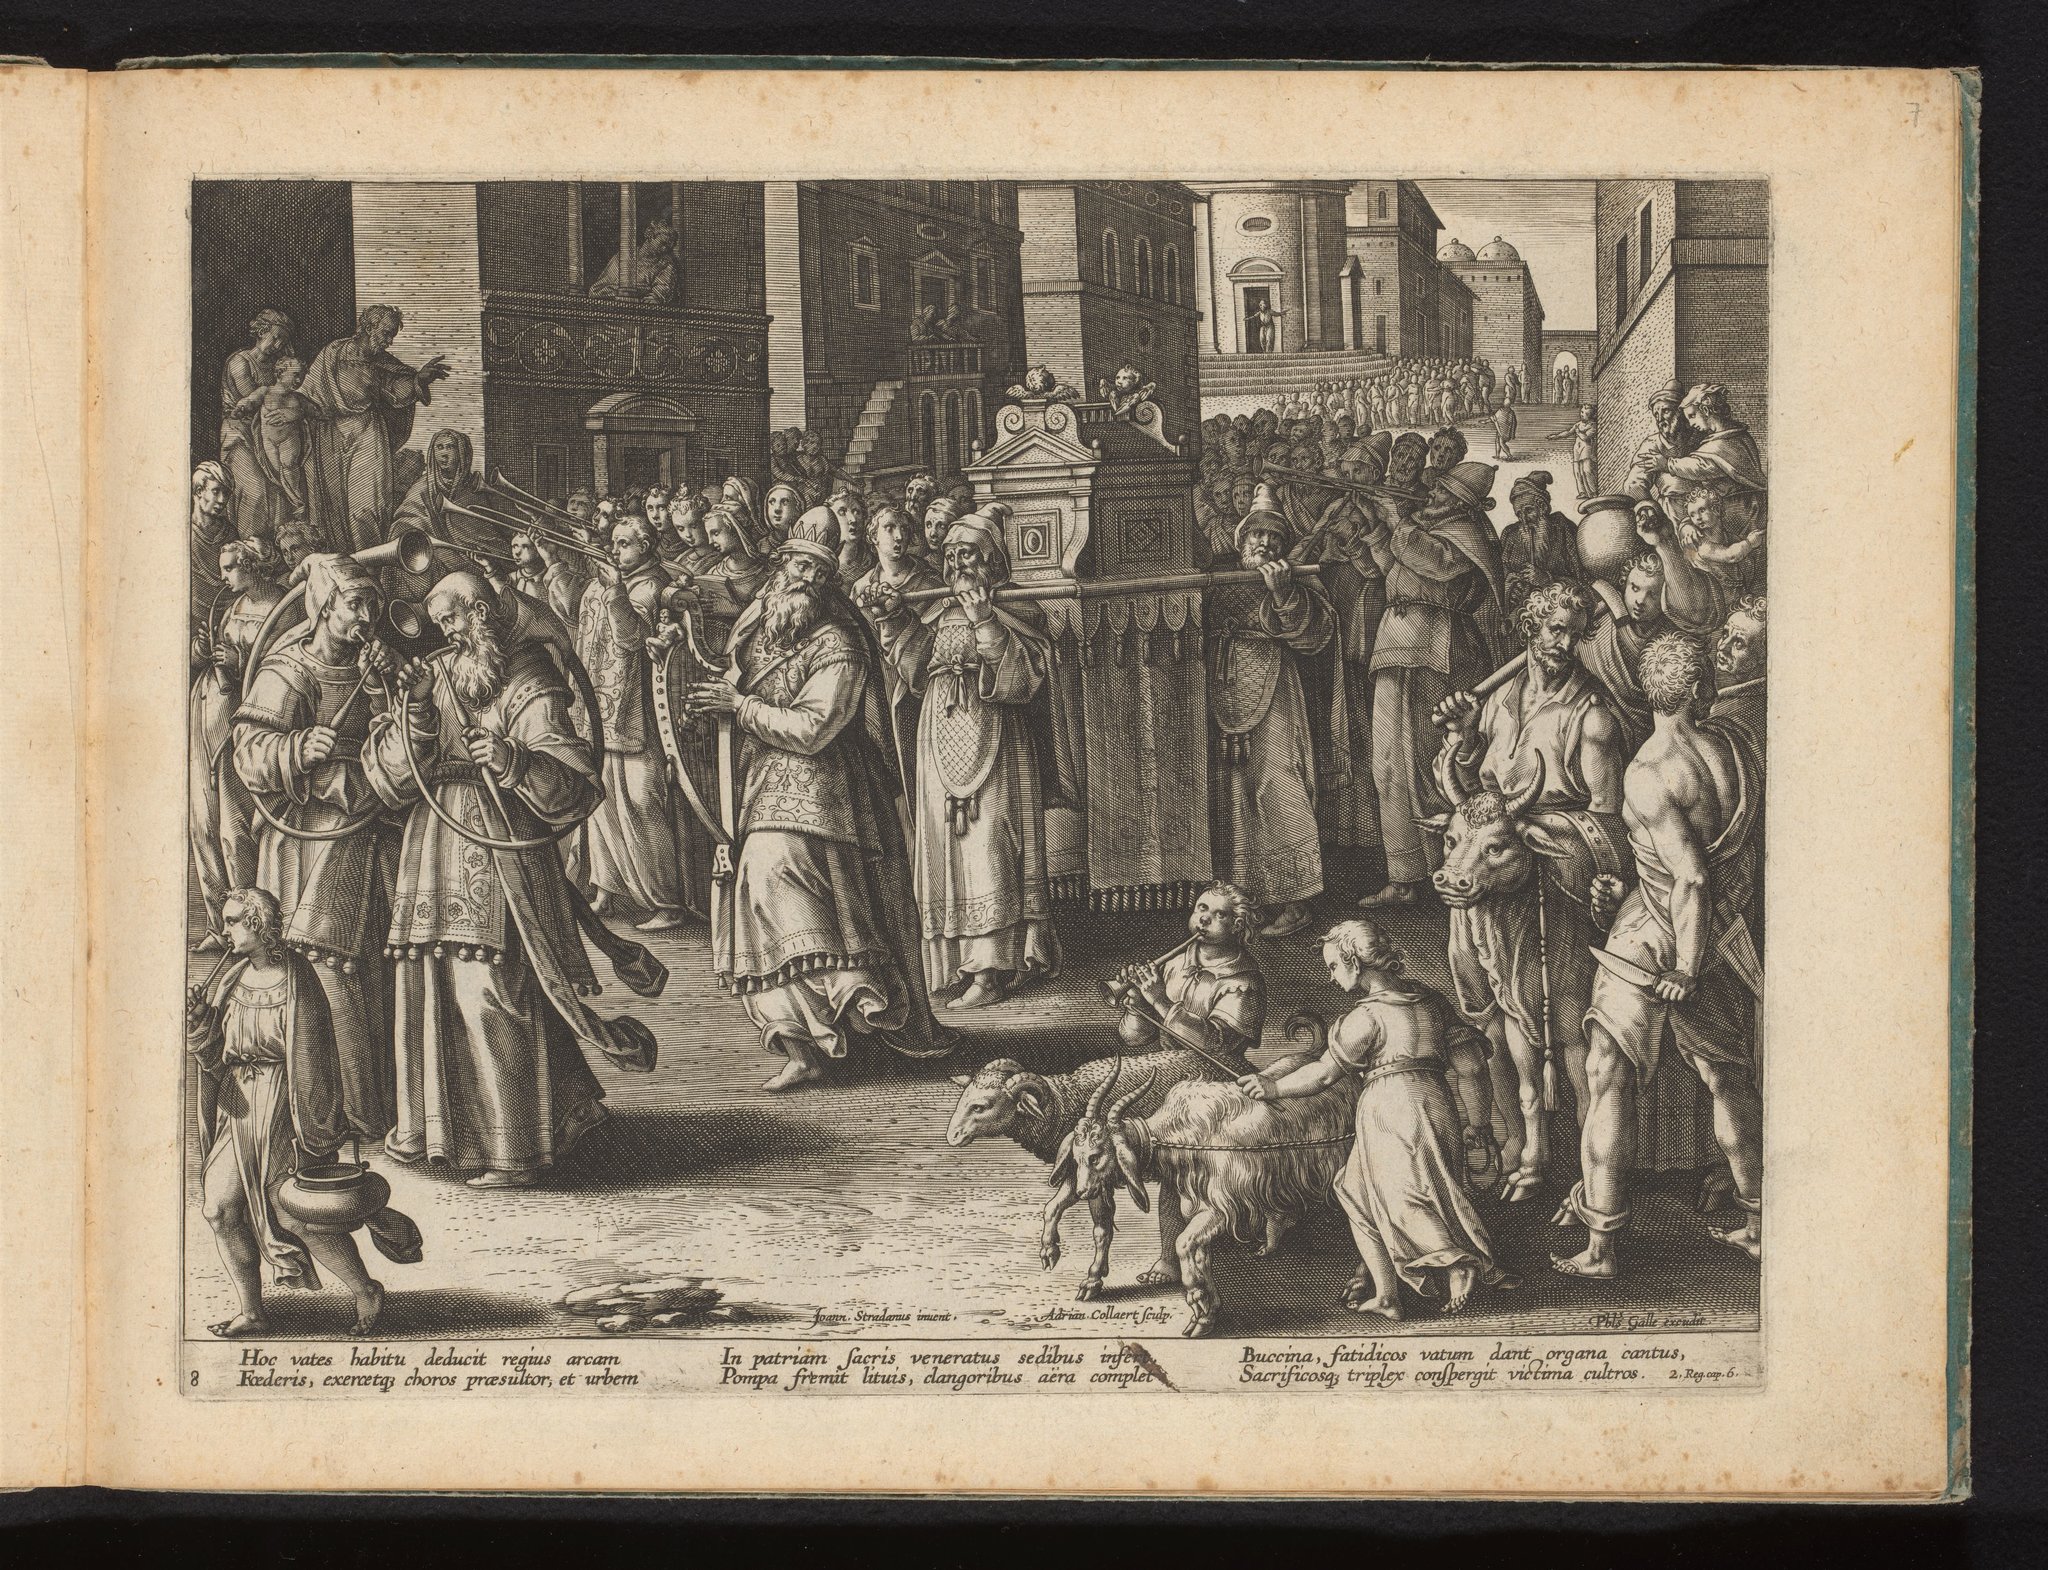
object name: album leaf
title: Ark des Verbonds naar Jeruzalem gebracht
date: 1587-1592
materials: paper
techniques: engraving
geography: antwerp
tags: musical instruments; group of musical instruments, david brings the ark into jerusalem, dancing (half-)naked before the ark and making music, while the people rejoice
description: De Ark des Verbonds wordt Jeruzalem binnengedragen. Koning David loopt voor de Ark en speelt op zijn harp. Anderen Israëlieten blazen op bazuinen en hoorns. Rechts een ram, geit en stier. De prent heeft een Latijns onderschrift met verzen. Rechtsonder een verwijzing naar 2. Samuël 6